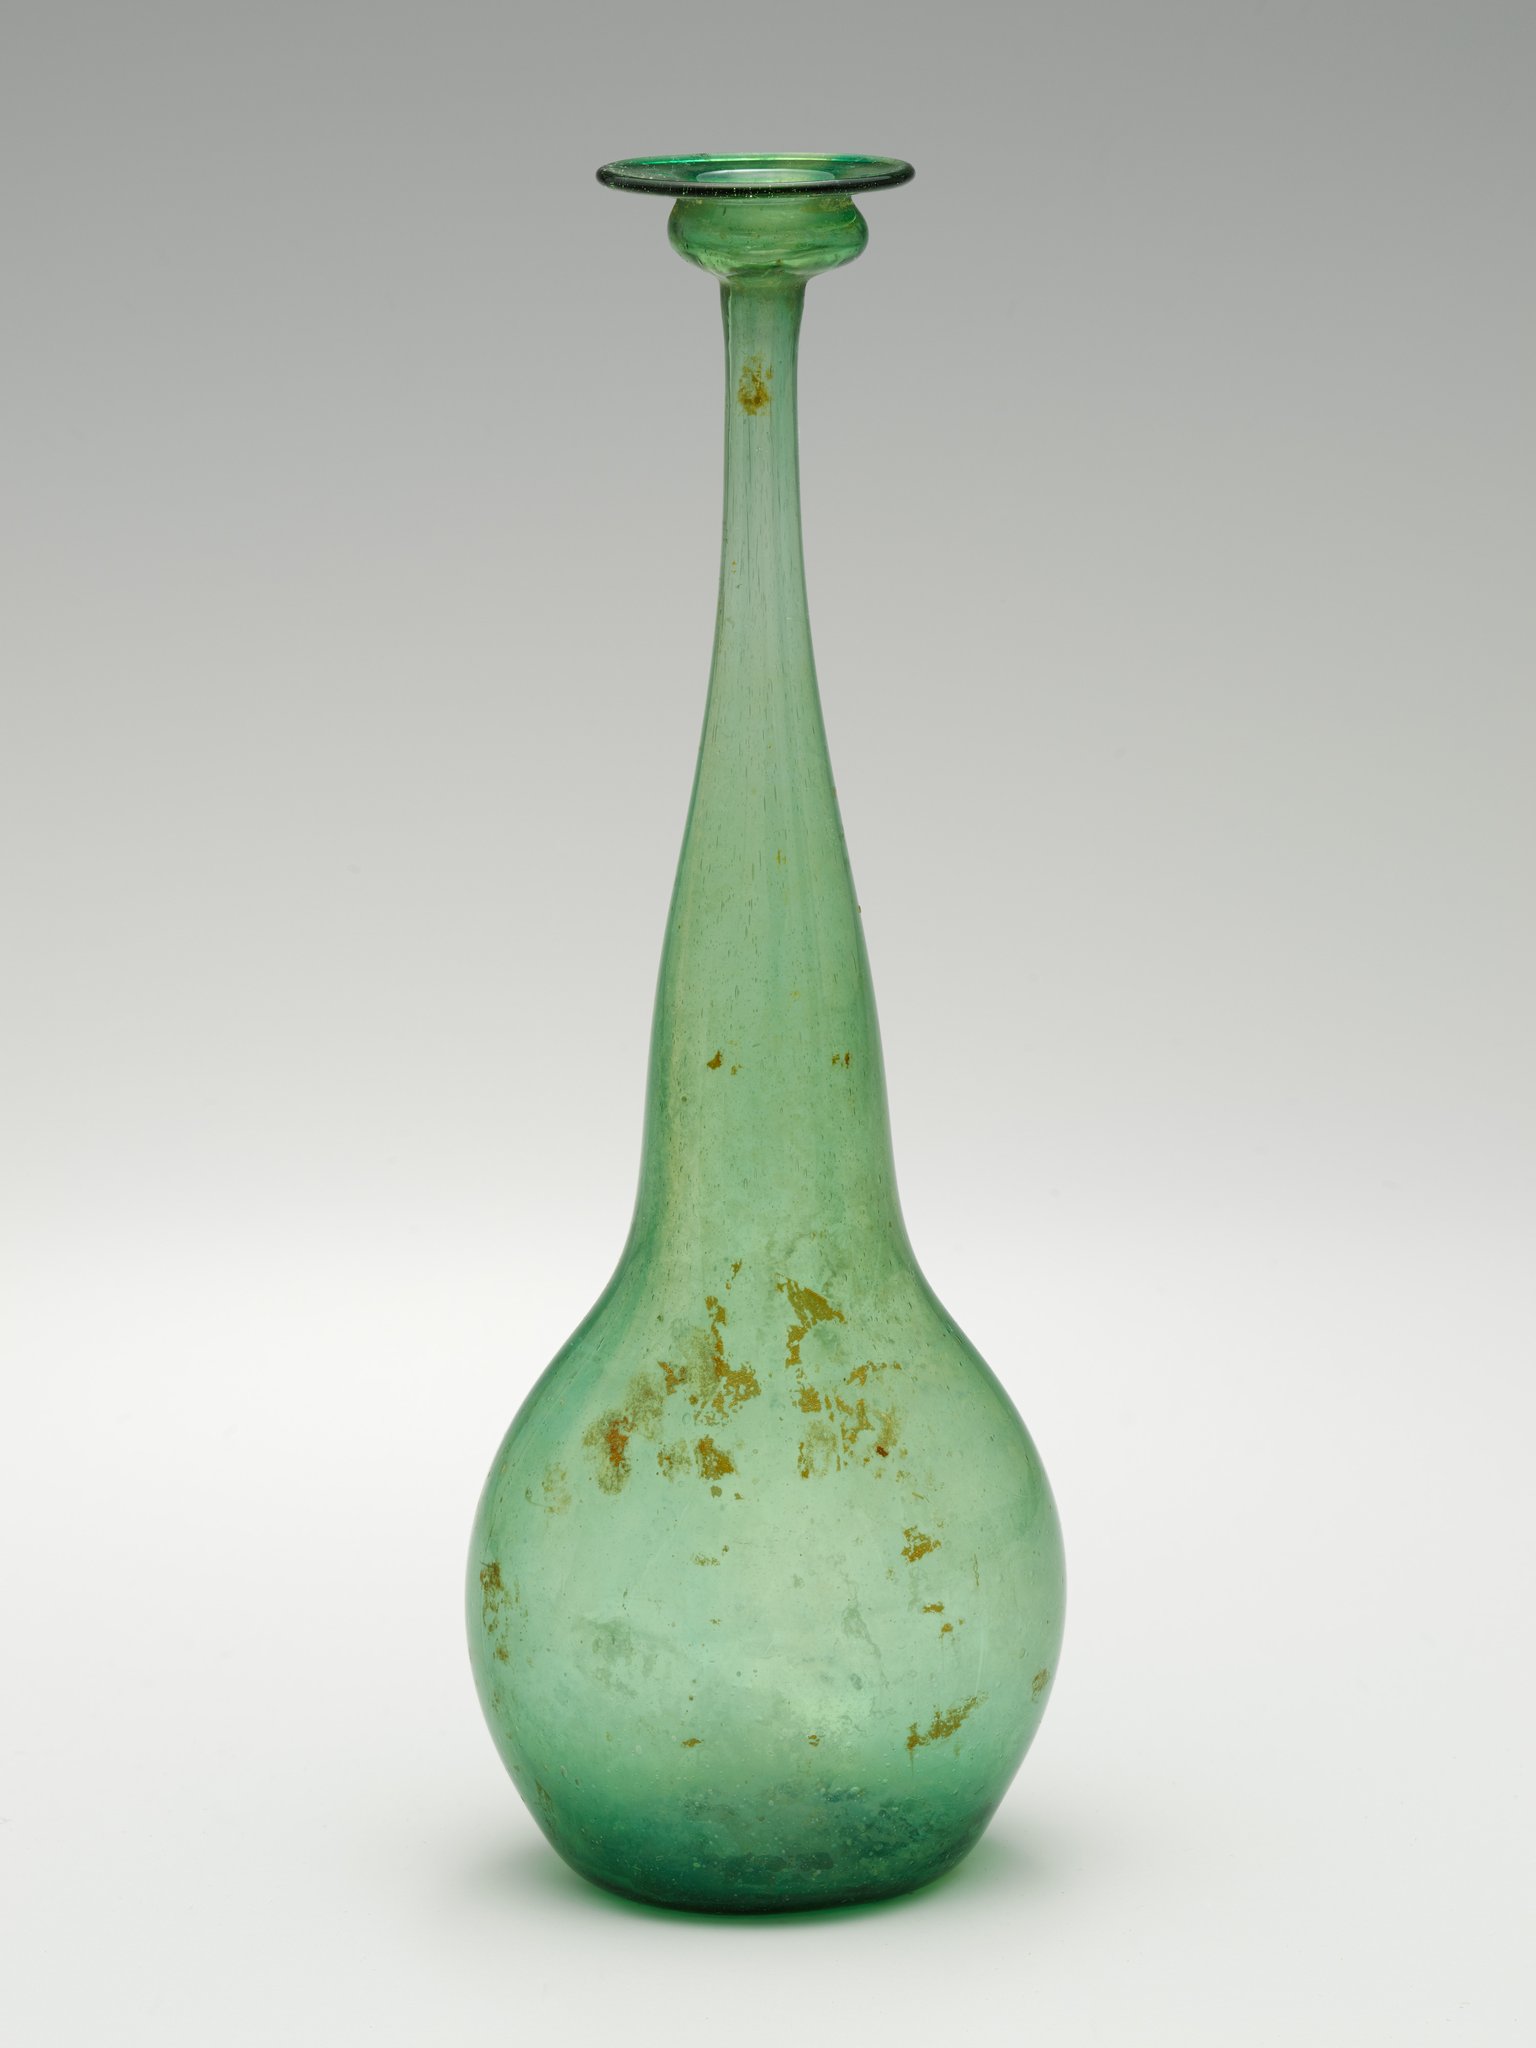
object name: sprinkler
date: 1701-1900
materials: glass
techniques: glassblowing, tooling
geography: iran